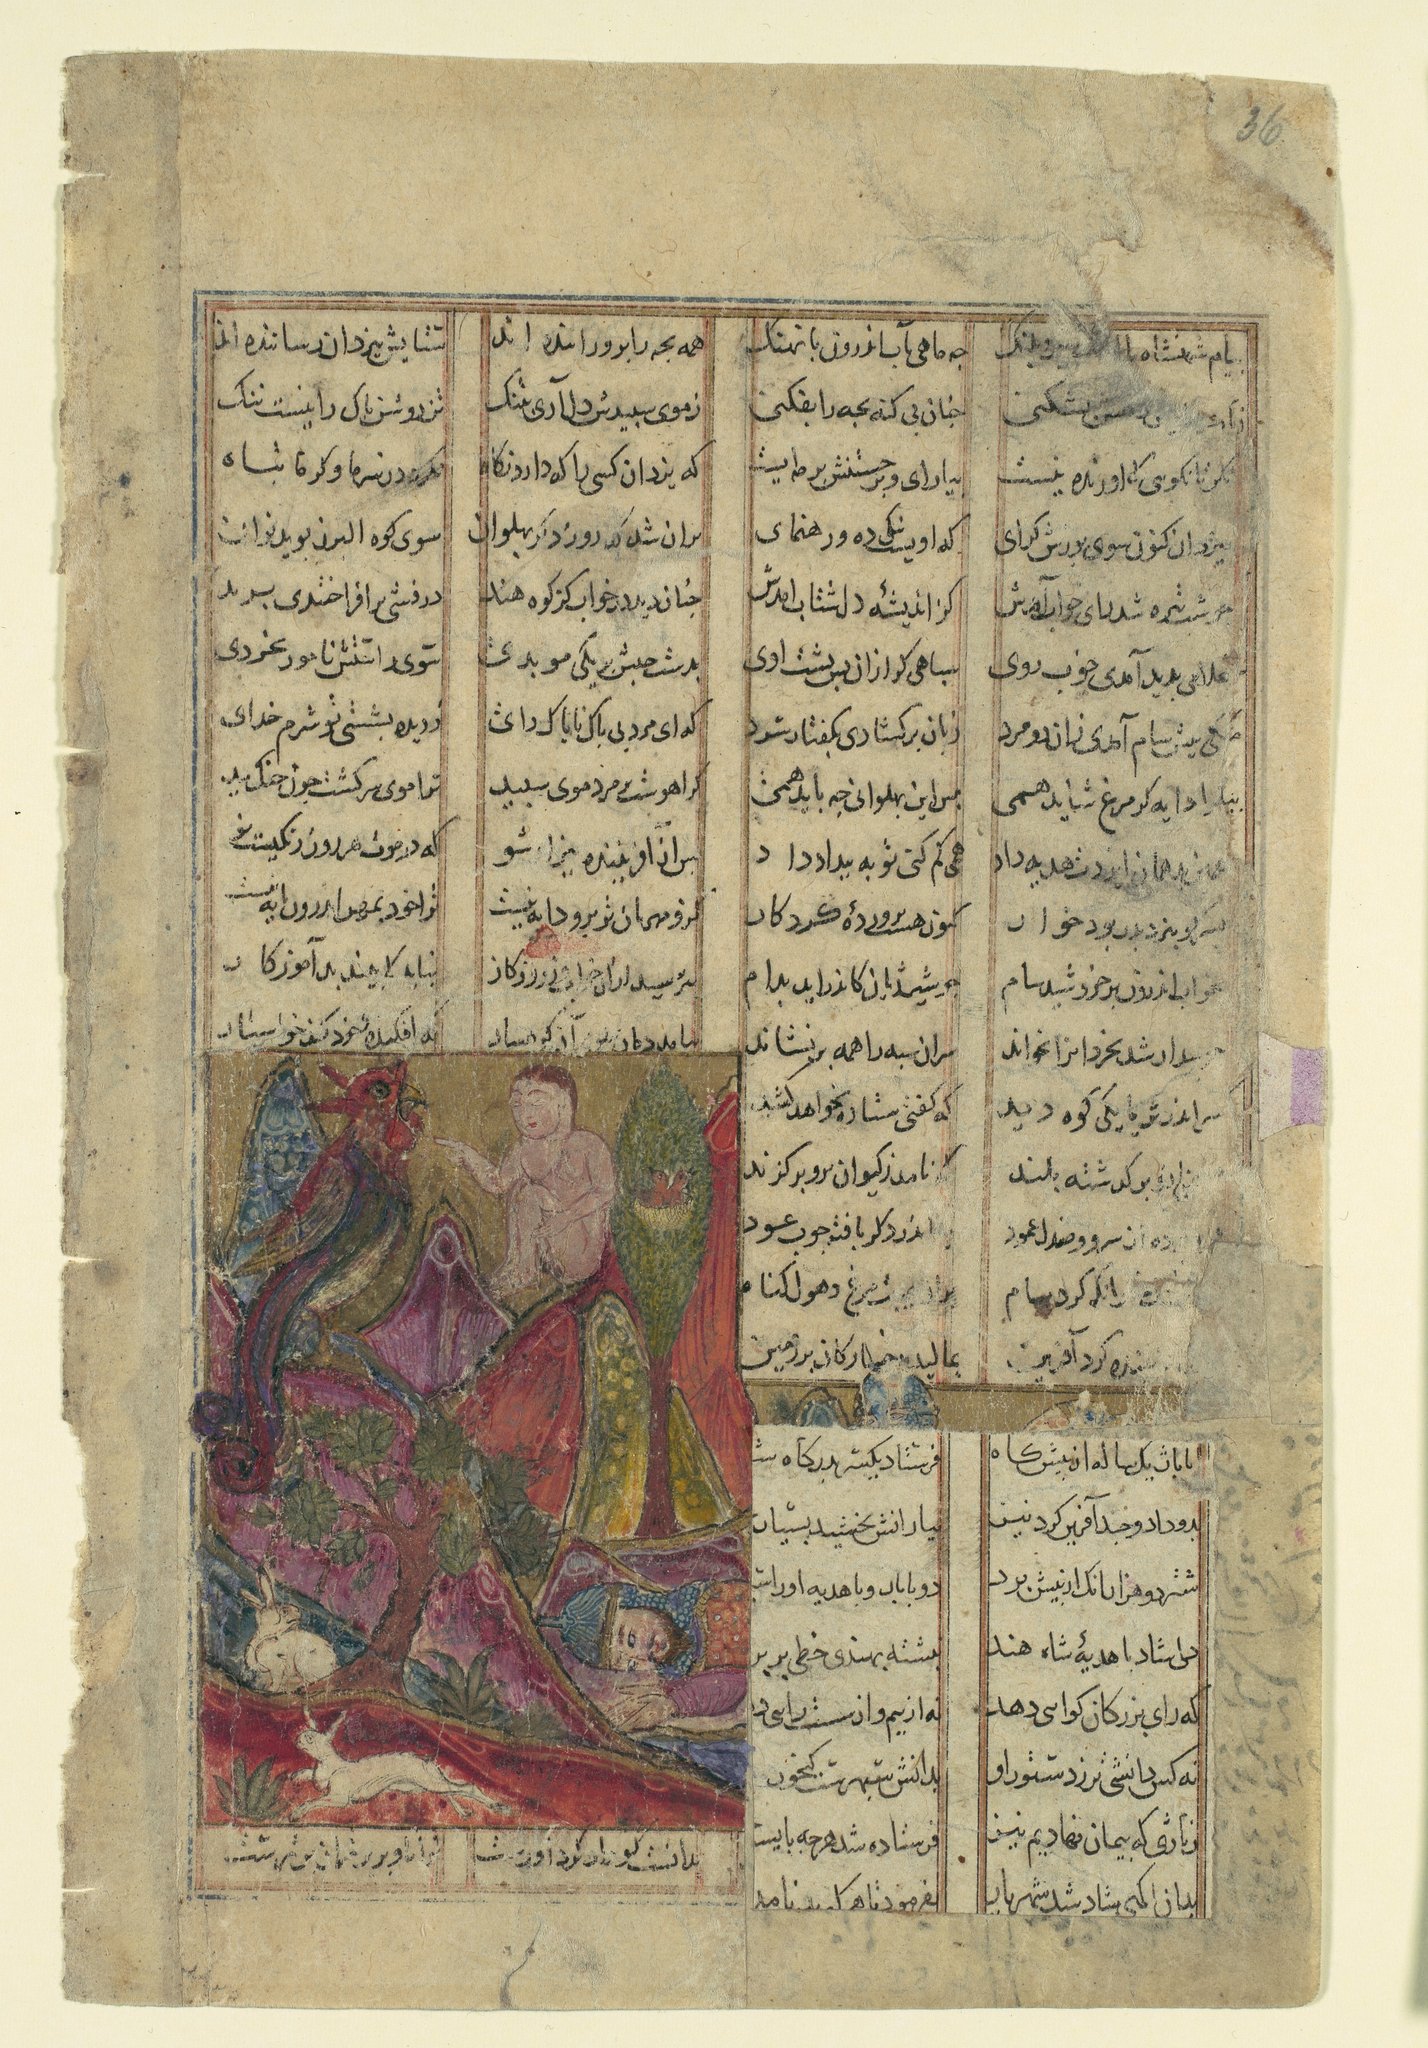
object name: folio from an illustrated manuscript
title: "Zal in the Simurgh's Nest", Folio from a Shahnama (Book of Kings)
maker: abu'l qasim firdausi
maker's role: author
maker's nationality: iranian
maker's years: 935-1020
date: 1330-1340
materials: gold, ink, paper, silver, watercolor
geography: iran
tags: animals,men,mythical creatures